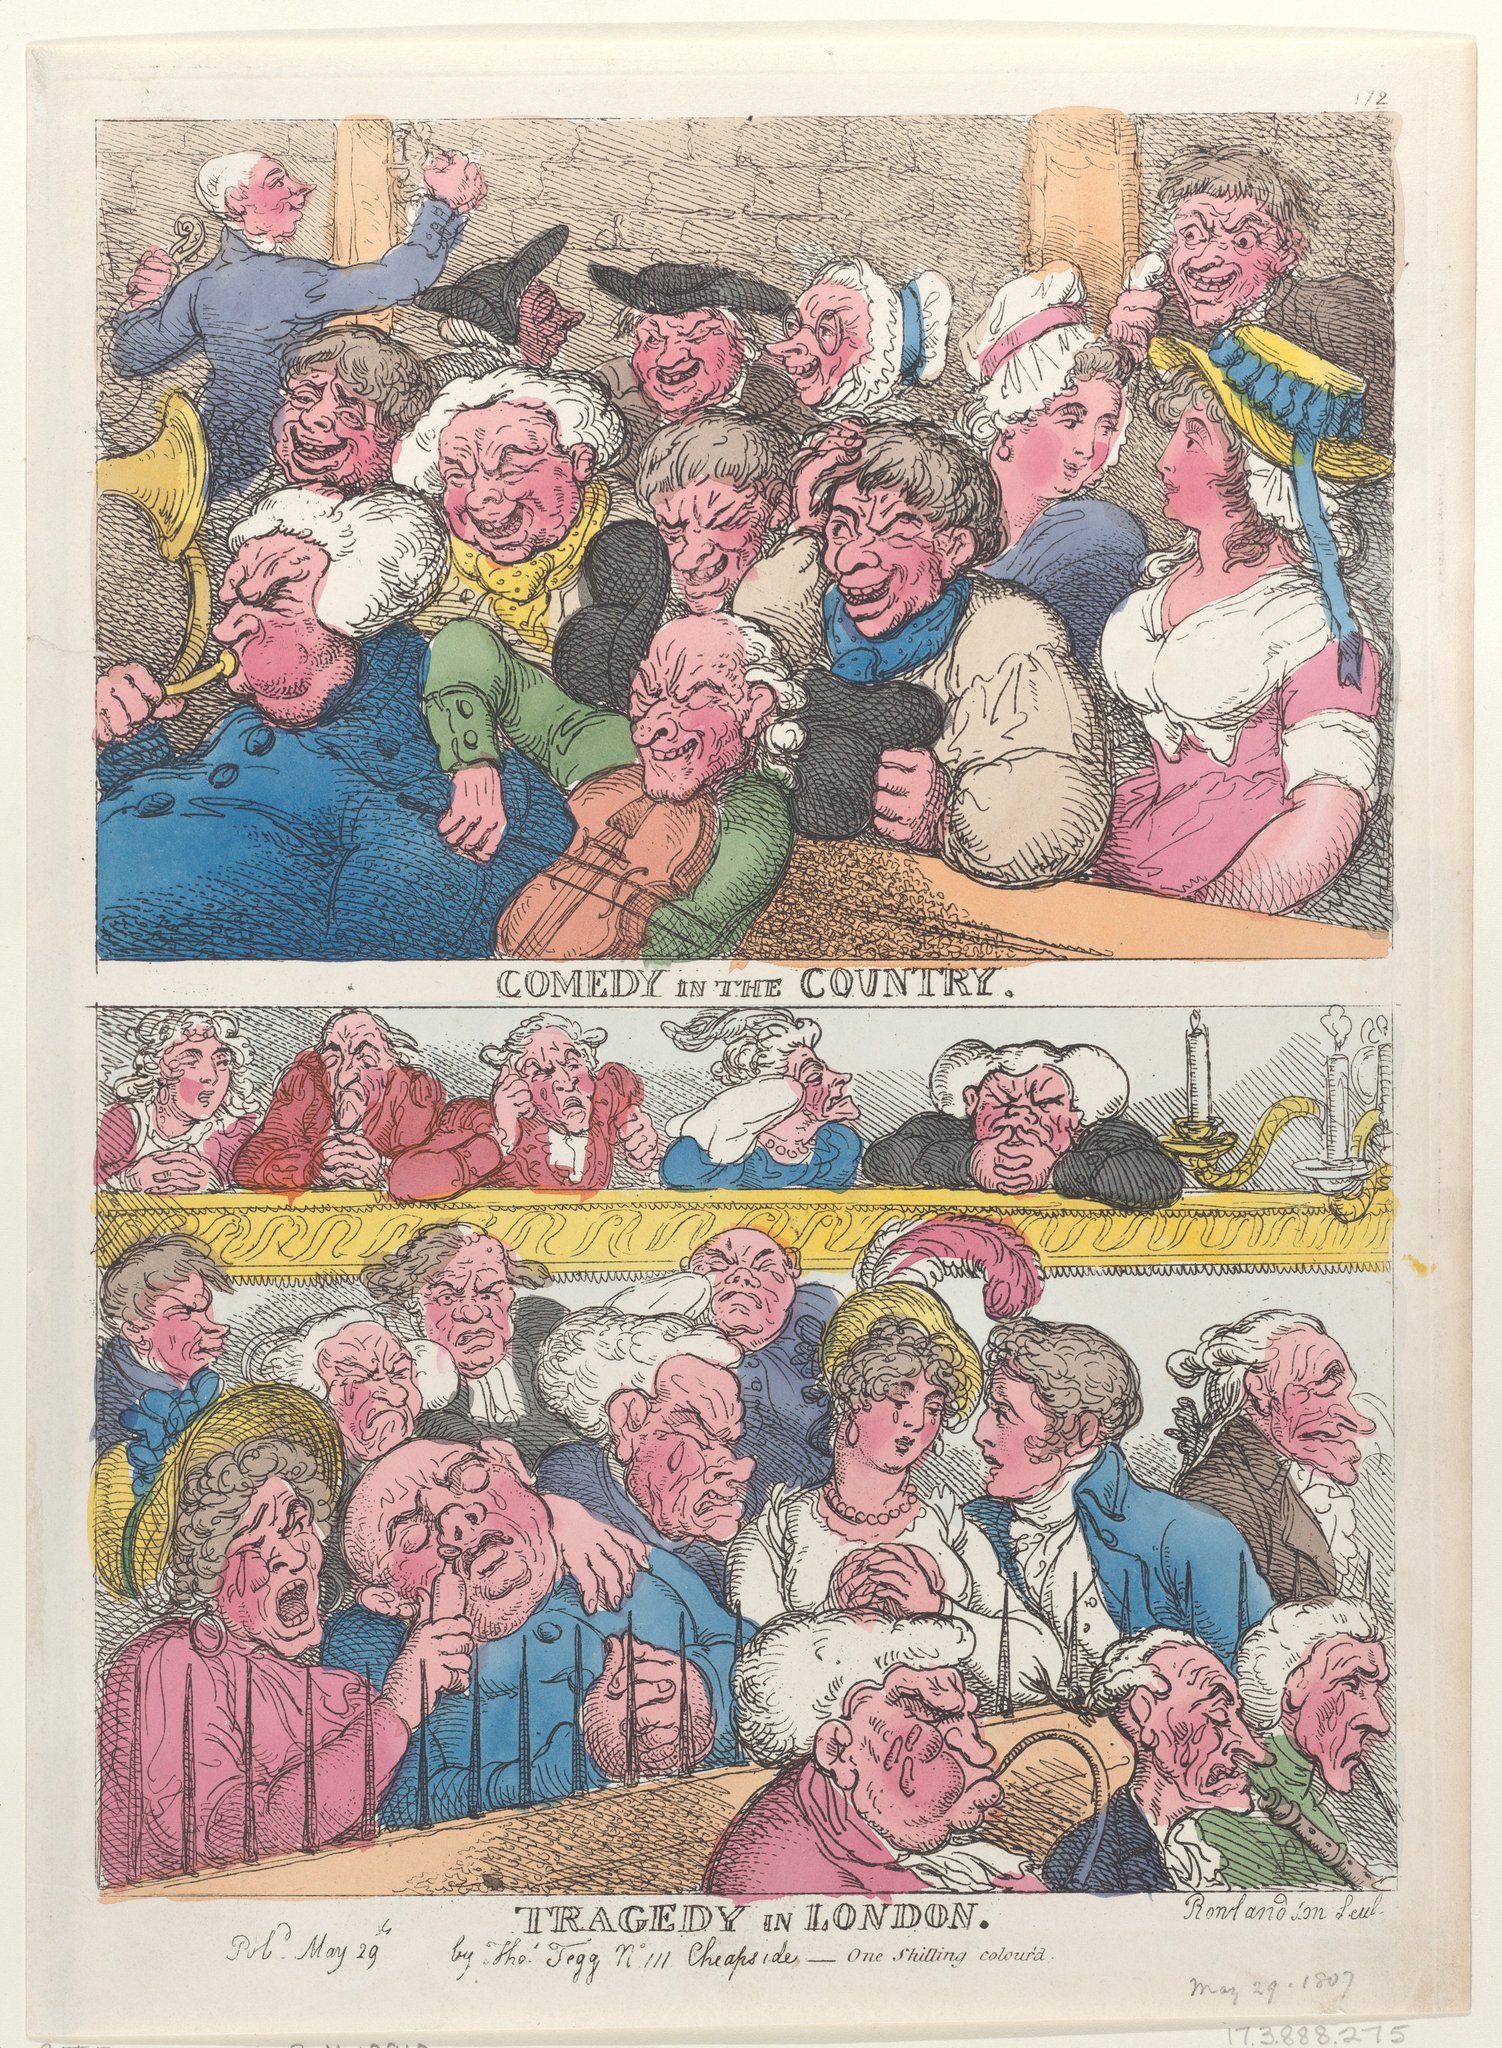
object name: print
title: Comedy in the Country, Tragedy in London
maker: thomas rowlandson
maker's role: artist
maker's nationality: british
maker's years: 1757-1827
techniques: etching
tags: satire,men,women,spectators